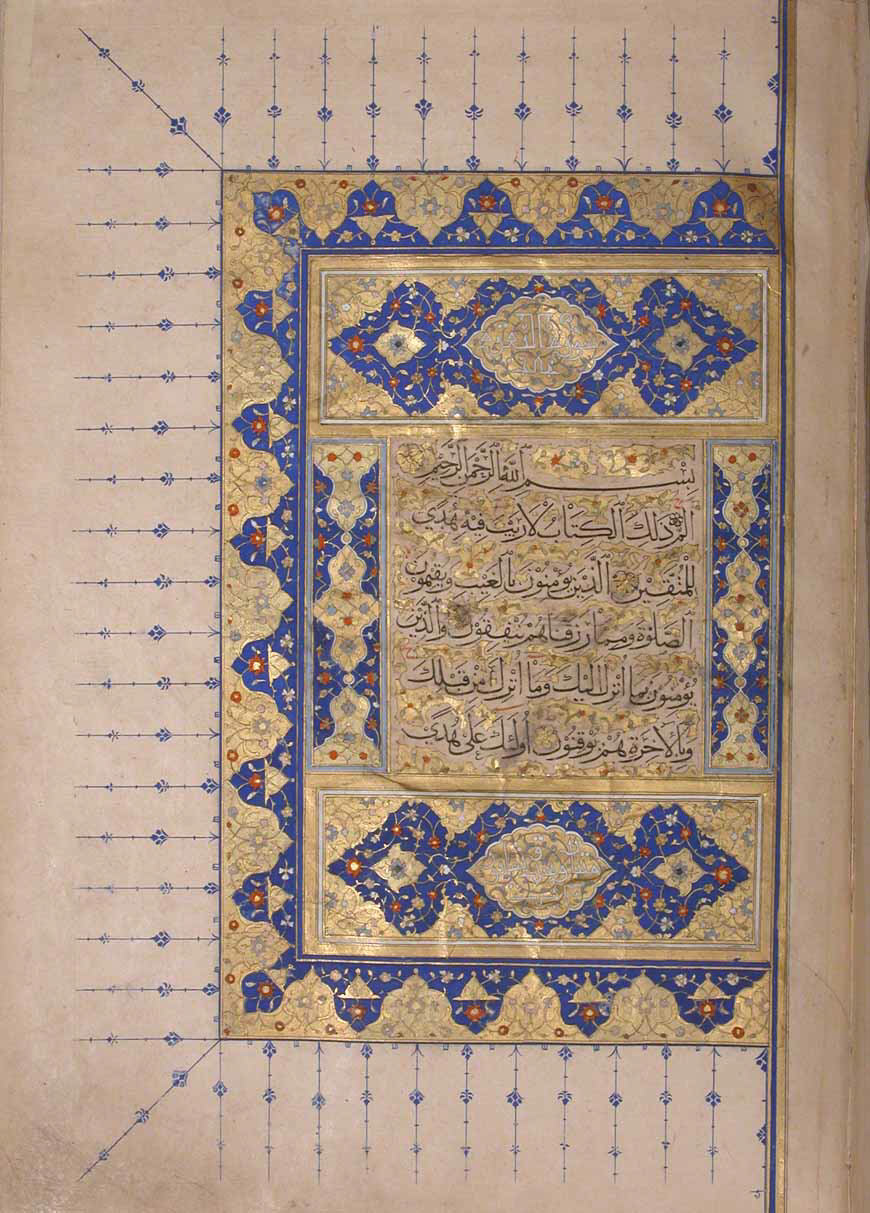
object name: non illustrated manuscript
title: Qur'an Manuscript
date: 1567-1633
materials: gilt, gold, ink, leather, paper, watercolor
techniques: stamping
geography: iran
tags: qur'an